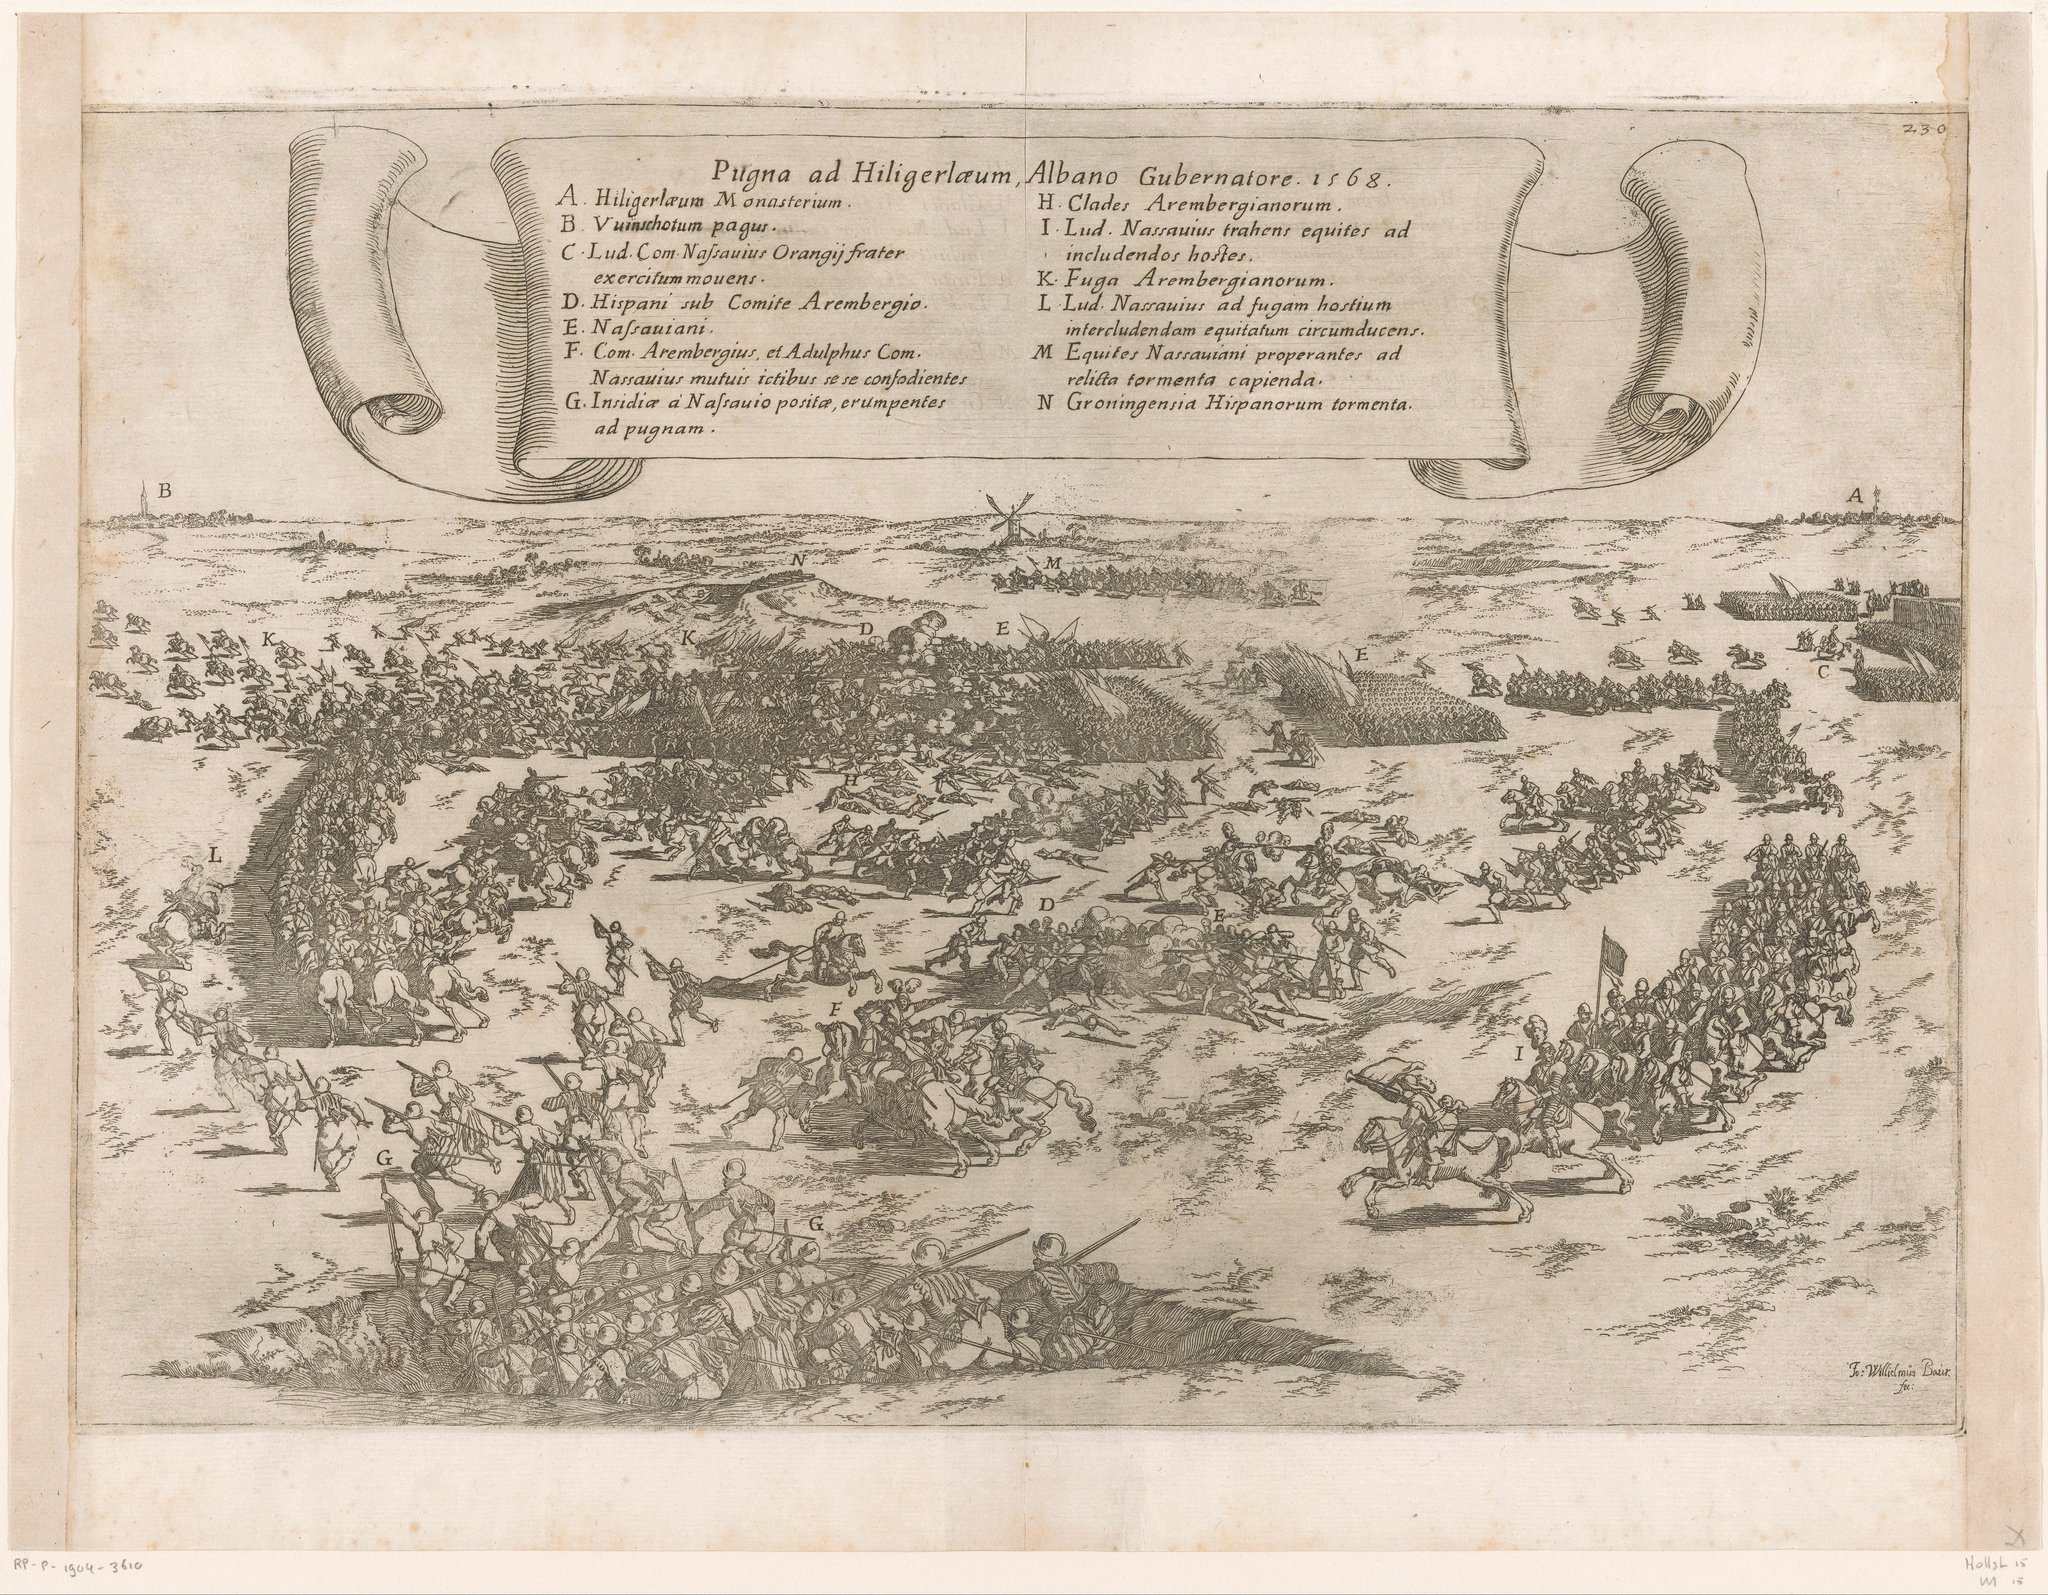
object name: history print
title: Pugna ad Hiligerlaeum, Albano Gubernatore. 1568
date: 1632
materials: paper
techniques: etching, intaglio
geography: rome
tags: jean de ligne (duke of arenberg), battle, fighting in general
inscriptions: number: ‘230’, collector's mark: Lugt 2228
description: Slag bij Heiligerlee, 23 mei 1568. Gezicht op het slagveld, in de verte Heiligerlee en Winschoten. Met opschrift in de plaat boven de voorstelling op banderol met legenda A-N in het Latijn. Rechtsboven genummerd: 230.